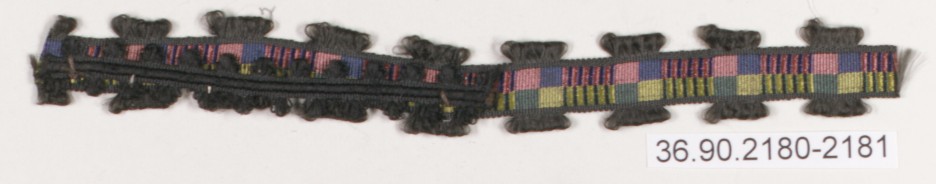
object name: piece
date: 1801-1900